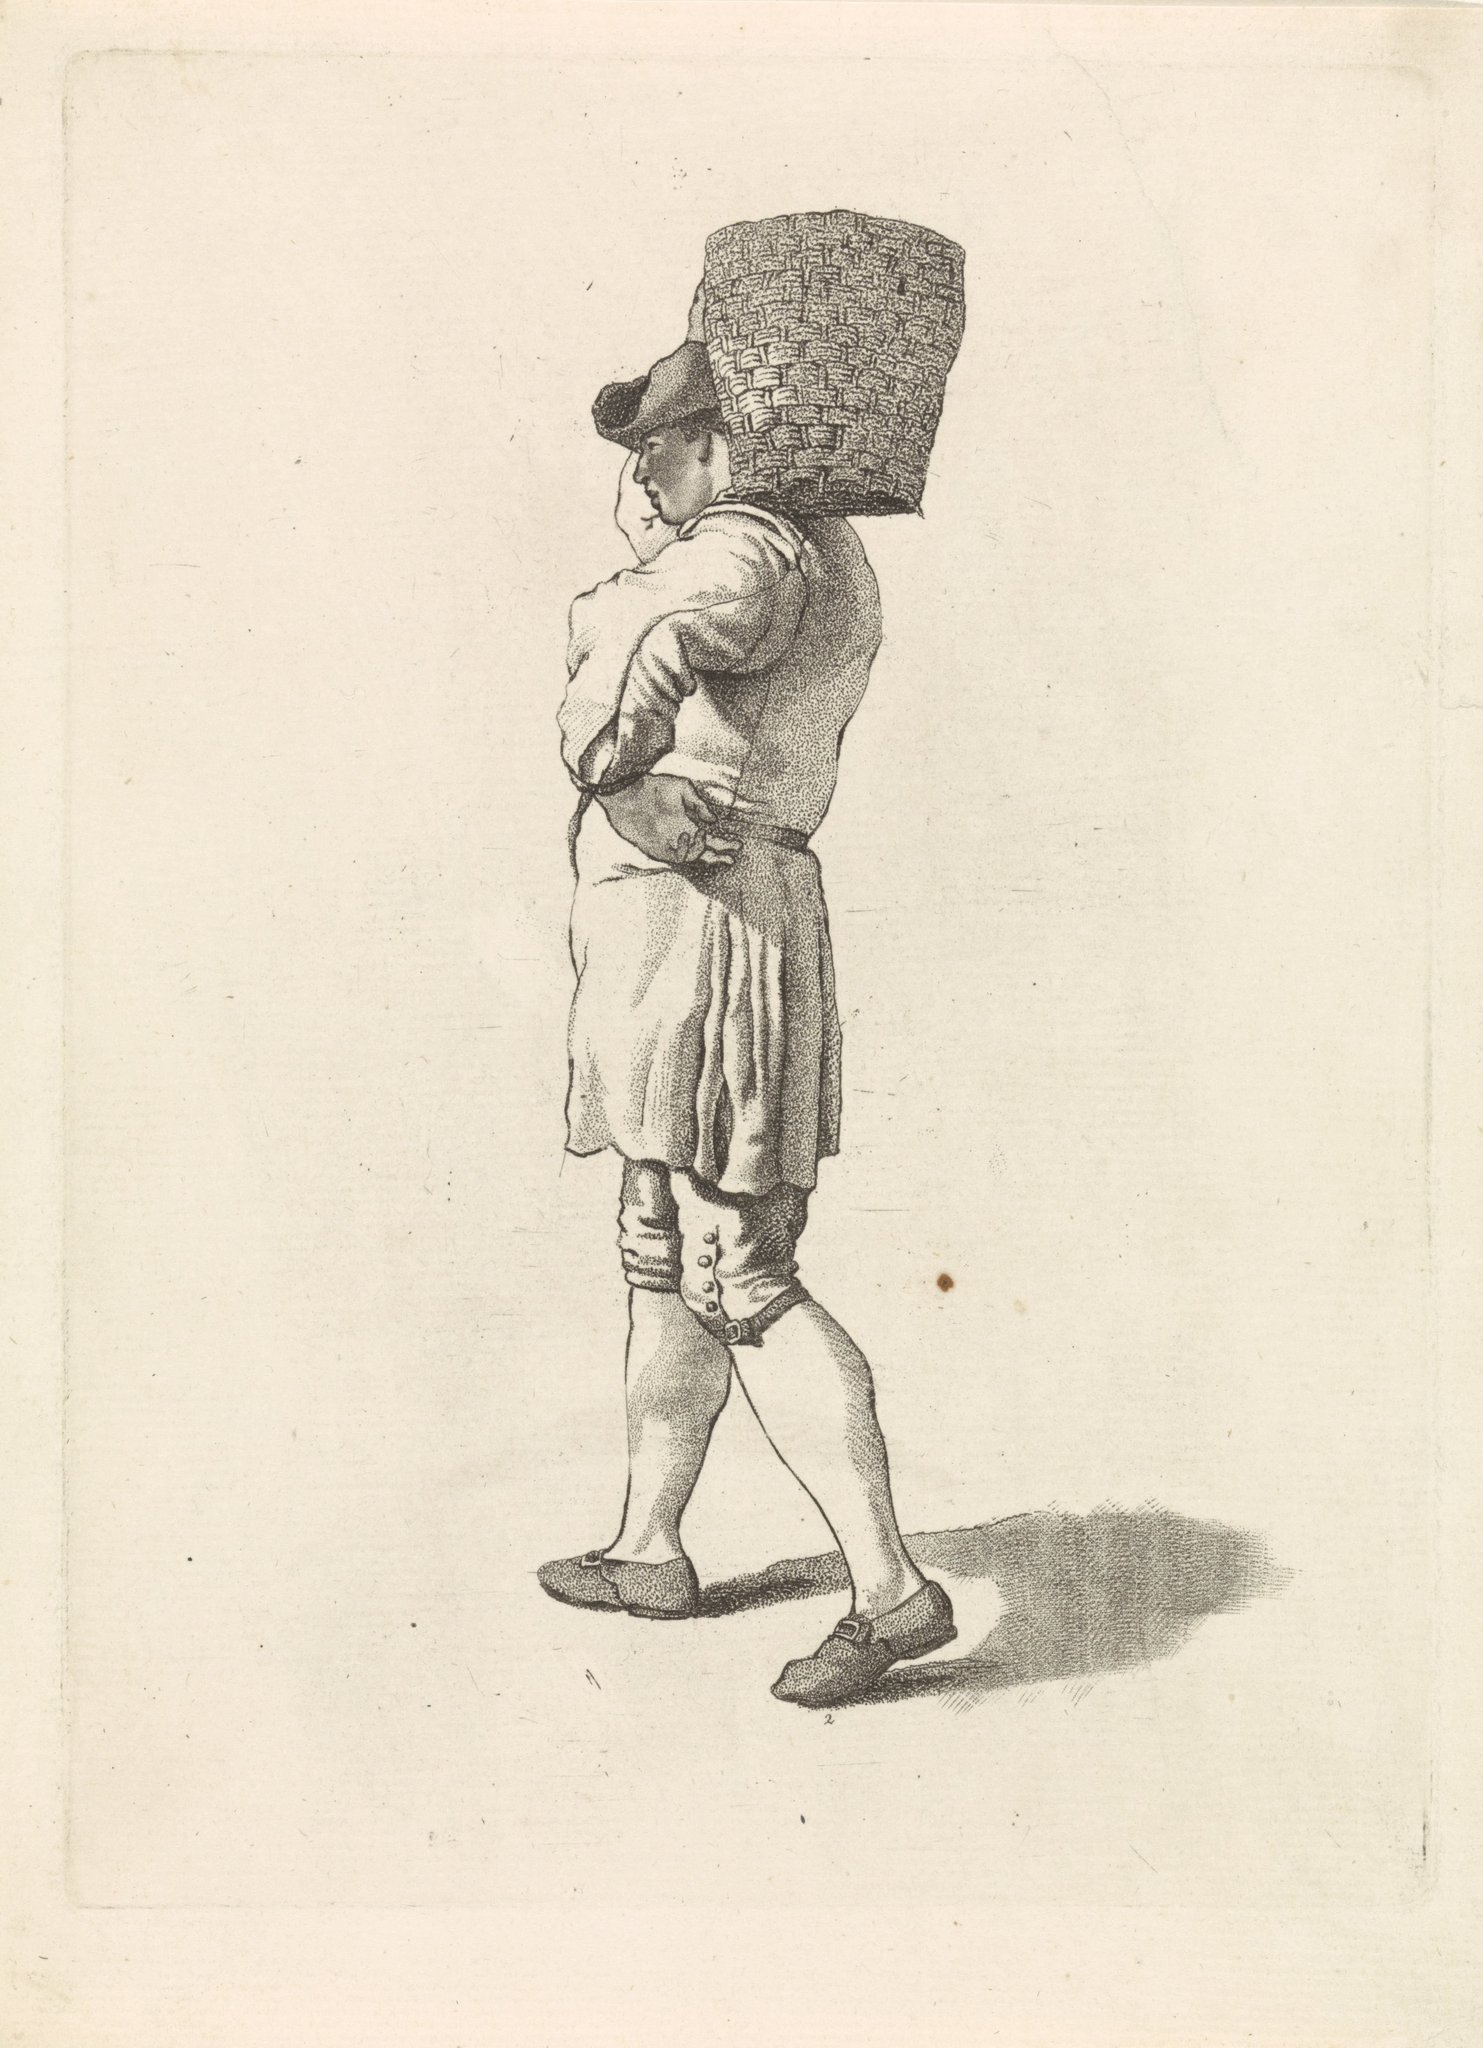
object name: print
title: Man draagt een mand op zijn schouder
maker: mathias de sallieth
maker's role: print maker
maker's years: 1749-1791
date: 1772-1791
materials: paper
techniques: printmaking, etching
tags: carrying something on the head or on the shoulders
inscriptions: collector's mark: Lugt 2228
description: De prent verscheen vanaf 1818 tevens als onderdeel van een 33-delige reeks prenten door Mathias de Sallieth, samengebonden in: Perkois, Jacobus, Prins, Johannes Huibert. Verzameling van verschillende gekleede mans- en vrouwenstanden, ter oefening van jonge schilders en liefhebbers. Rotterdam: Johannes Immerzeel, 1818.